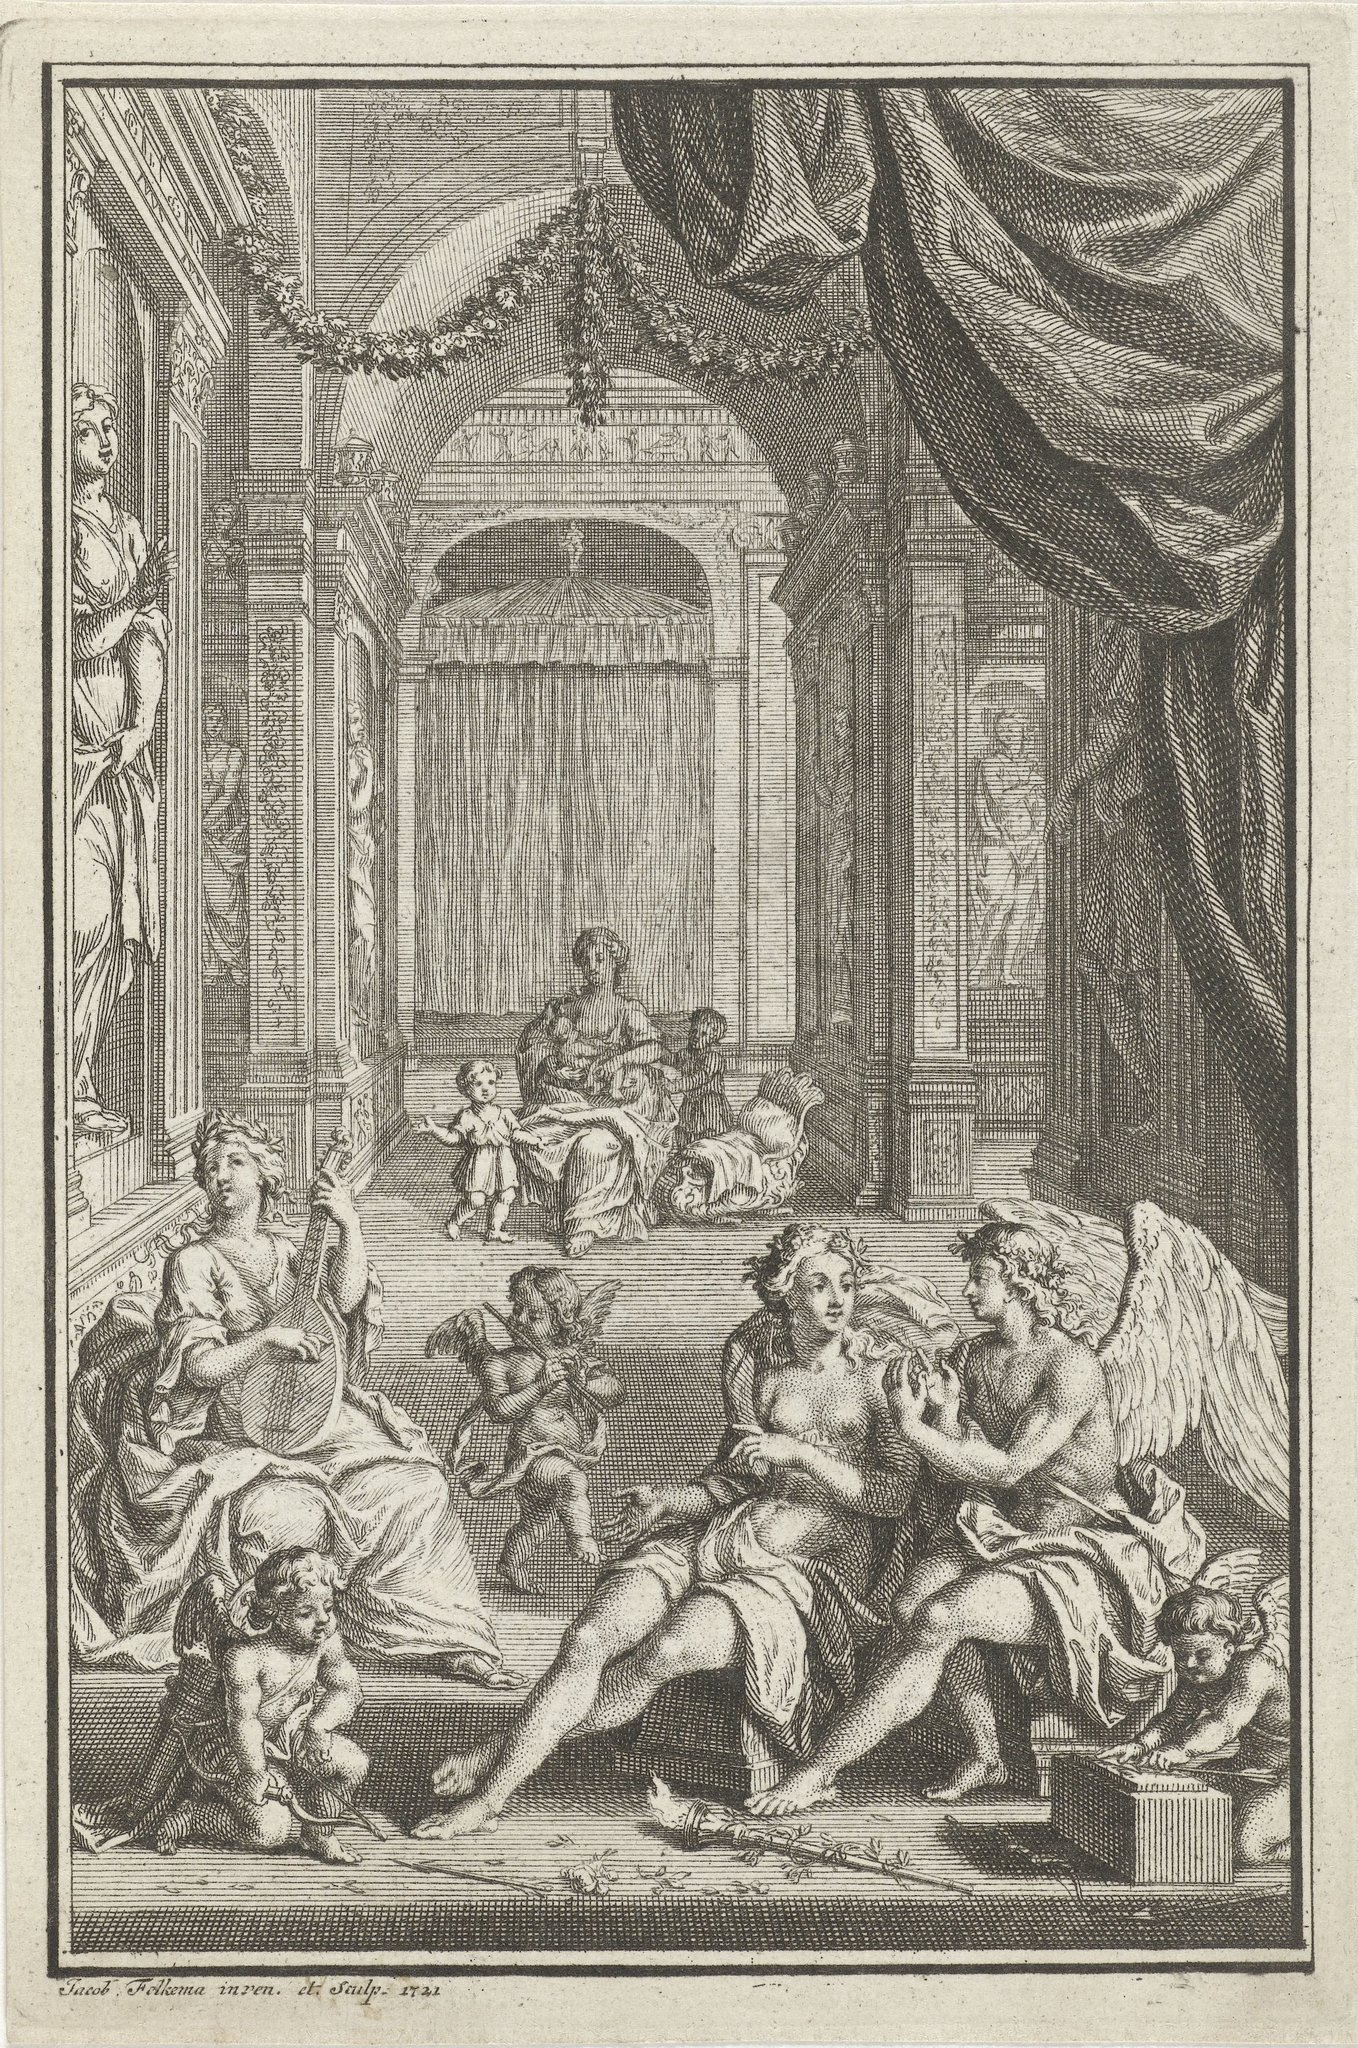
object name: print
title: Allegorische figuren in een tempel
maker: jacob folkema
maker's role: draughtsman, print maker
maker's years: 1692-1767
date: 1721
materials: paper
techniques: etching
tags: temperance, 'temperantia'; 'temperanza' (ripa) ~ one of the four cardinal virtues, cupids: 'amores', 'amoretti', 'putti', playing instruments (in church)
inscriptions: collector's mark: Lugt 2228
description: Een engel, drie putti en twee gelauwerde vrouwen zitten in een tempel. De vrouw links speelt de luit, een putto bespeelt achter haar de fluit. Rechts voeren een engel en een vrouw een gesprek terwijl om hen heen putti spelen met pijl en boog. Op de achtergrond zoogt een vrouw in het bijzijn van twee kinderen een baby.